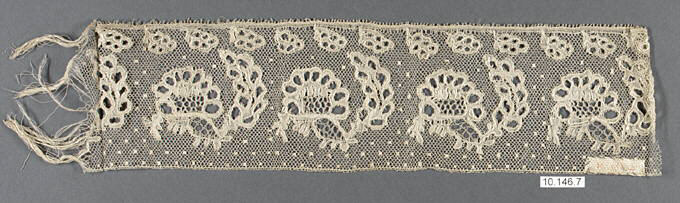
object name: piece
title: Pieces (2)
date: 1701-1800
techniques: lace